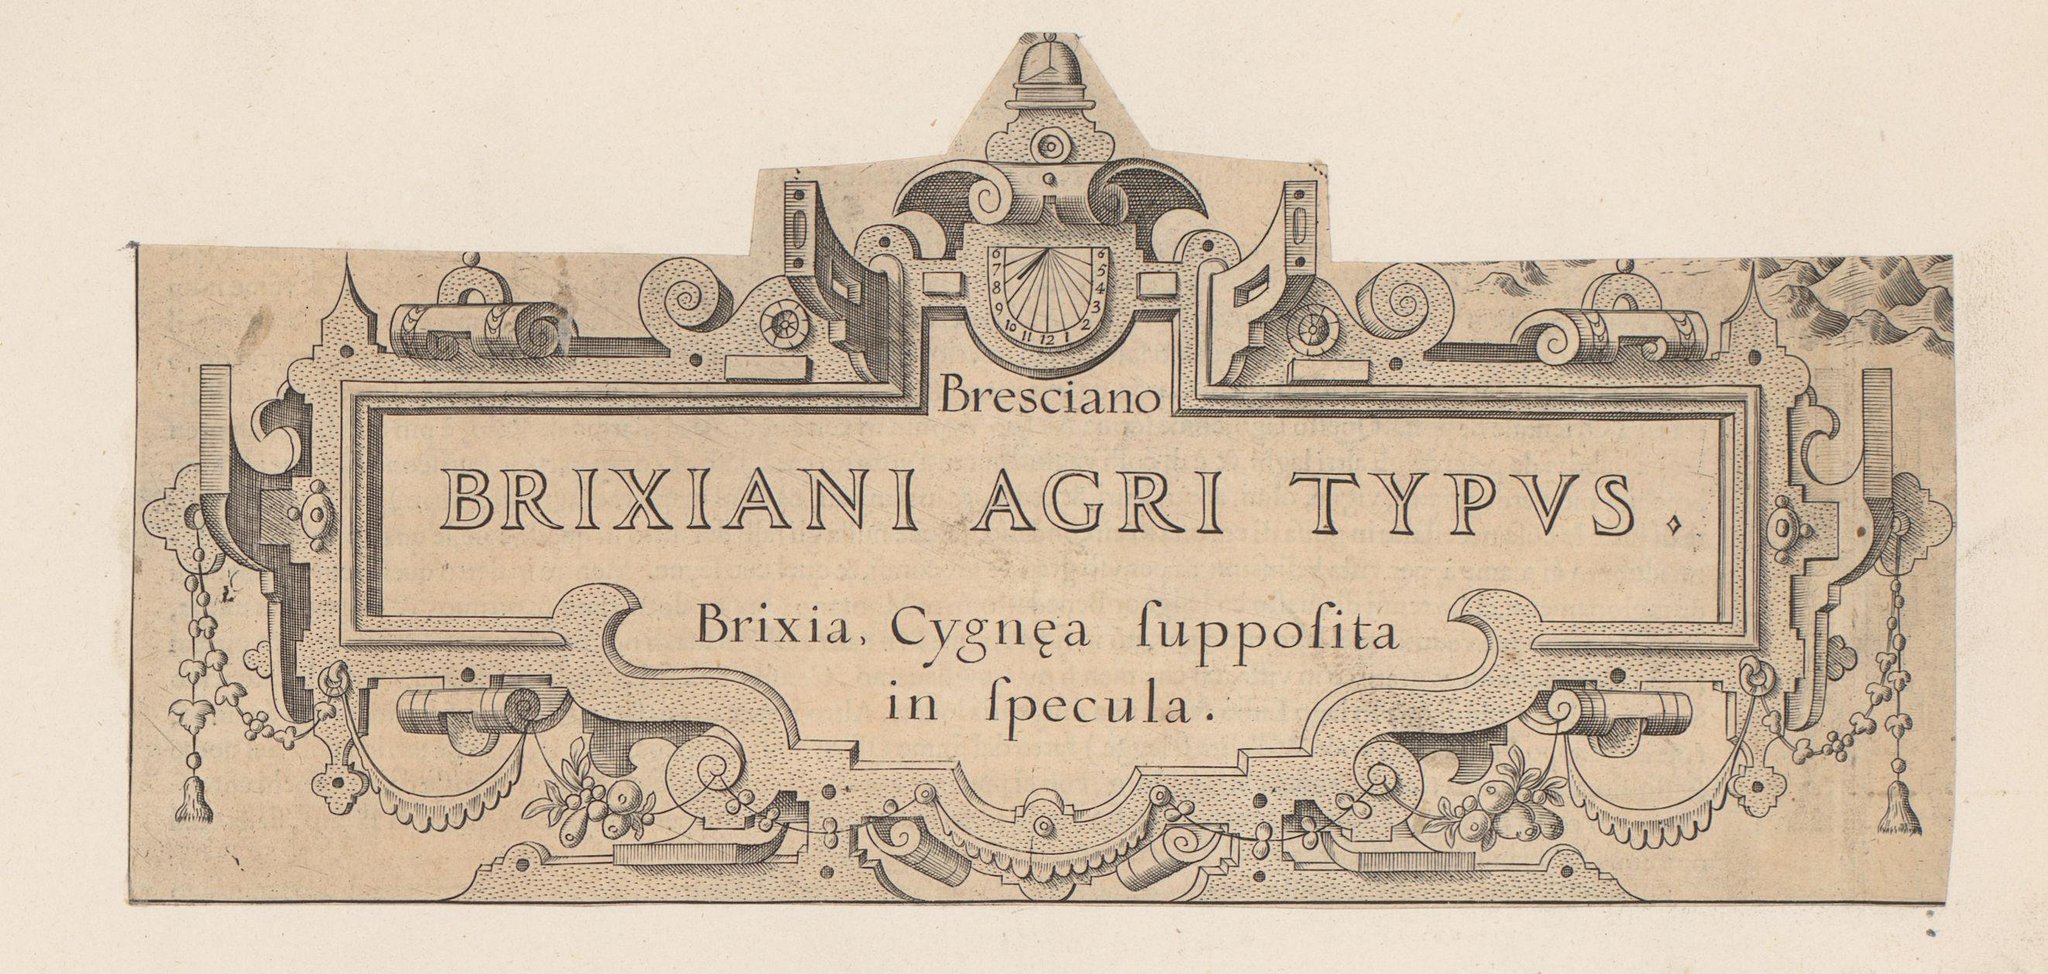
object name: album leaf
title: Langwerpige cartouche met zonnewijzer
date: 1590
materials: paper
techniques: engraving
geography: antwerp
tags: ornament ~ cartouche, sundial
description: Langwerpige cartouche met midden boven een zonnewijzer. De cartouche is een fragment van een kaart van Brescia. De prent maakt deel uit van een album.